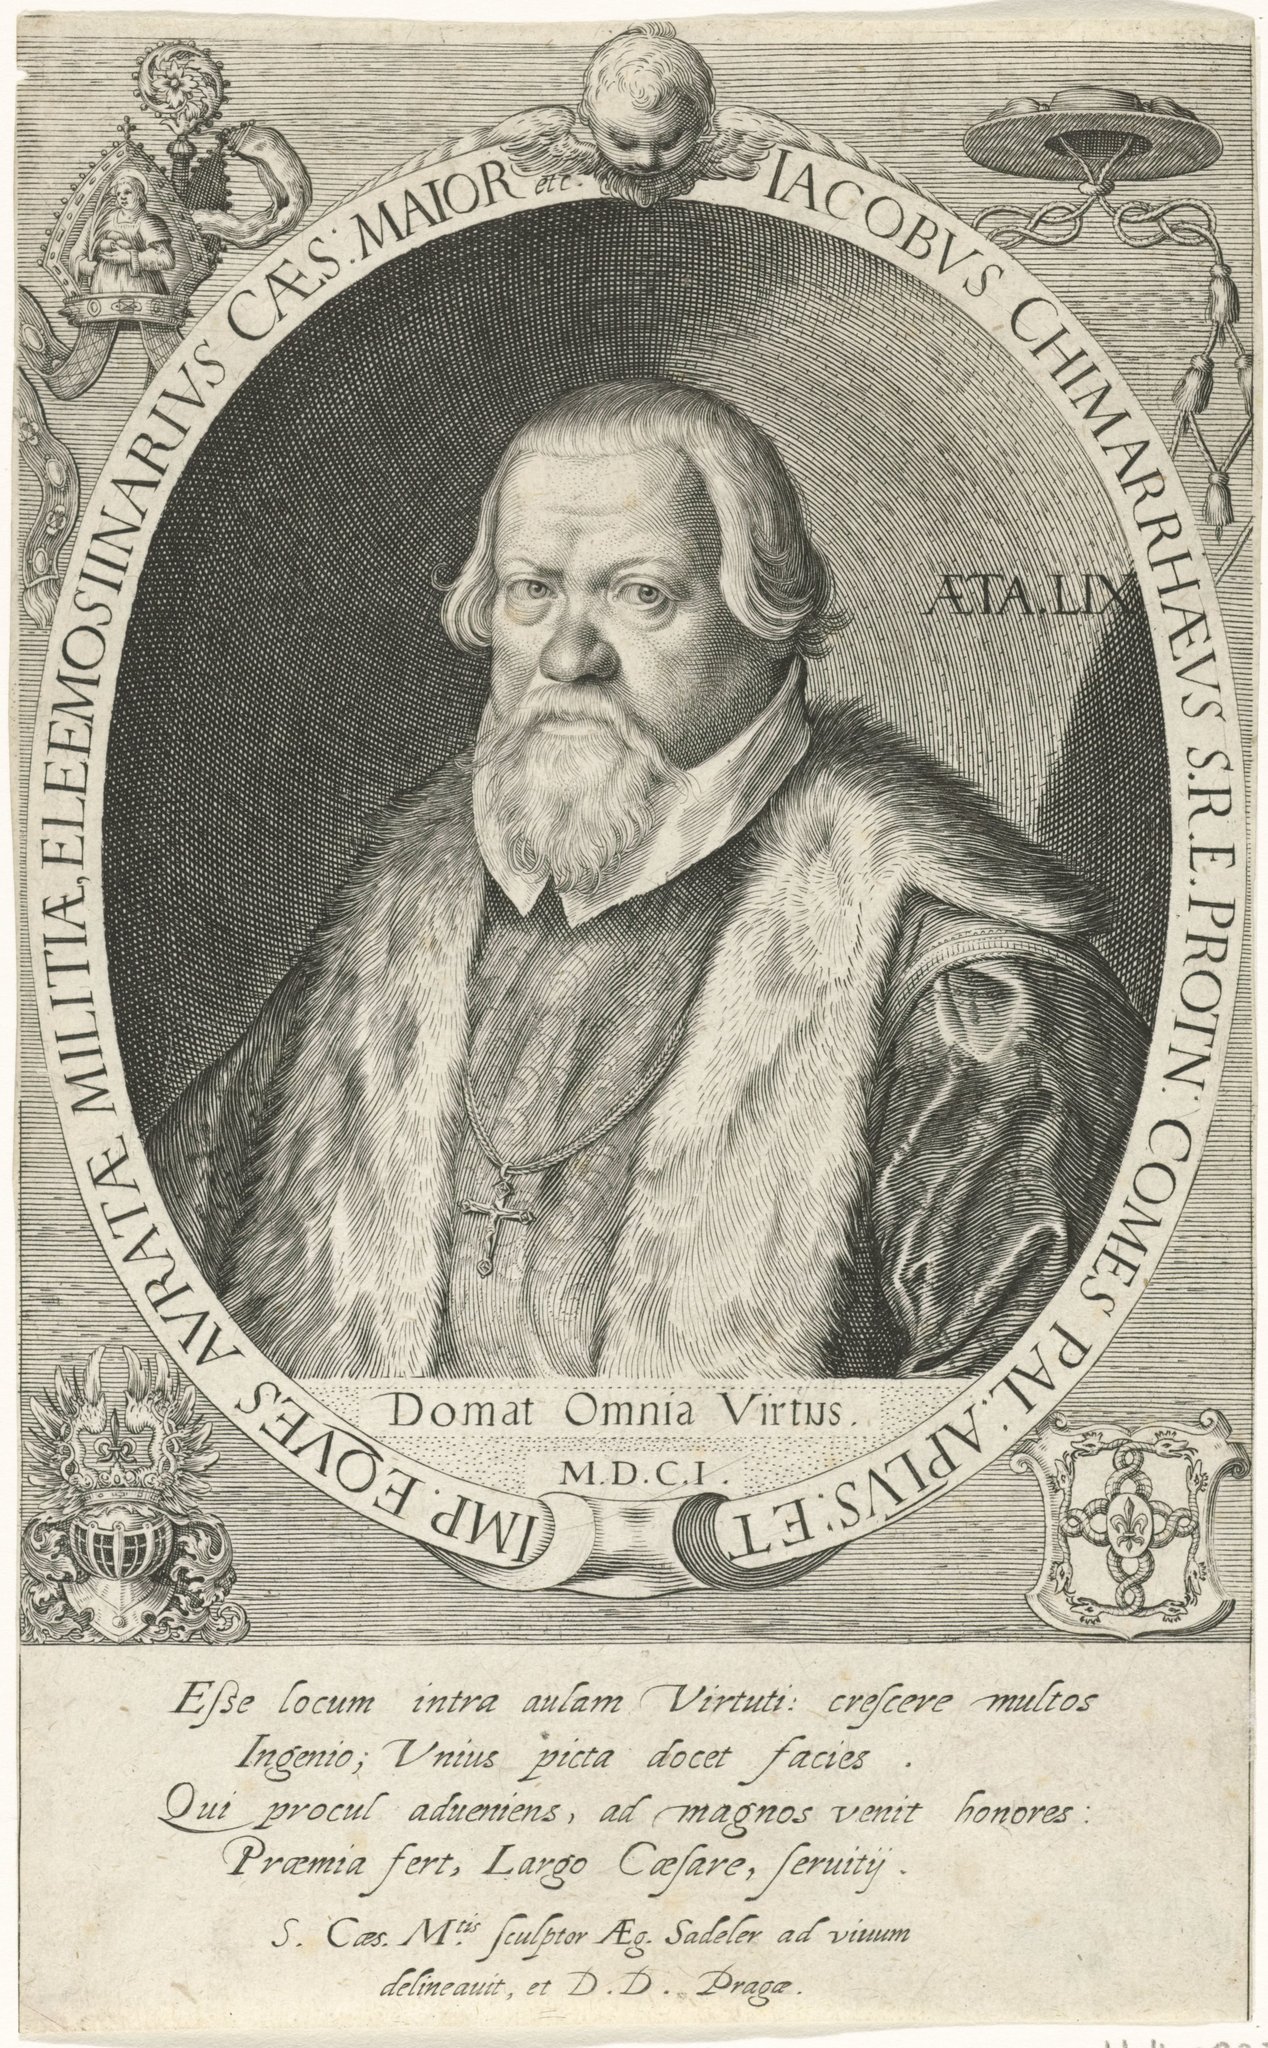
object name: print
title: Portret van predikant Jacob Chimarrhaeus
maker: aegidius sadeler (ii)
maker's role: draughtsman, print maker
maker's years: 1568-1629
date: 1601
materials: paper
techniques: engraving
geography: prague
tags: jacob chimarrhaeus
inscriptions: collector's mark: Lugt 240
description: Jacob Chimarrhaeus, componist en aalmoezenier aan het hof van Rudolf II. Portret op 59-jarige leeftijd. De prent heeft een Latijns onderschrift.